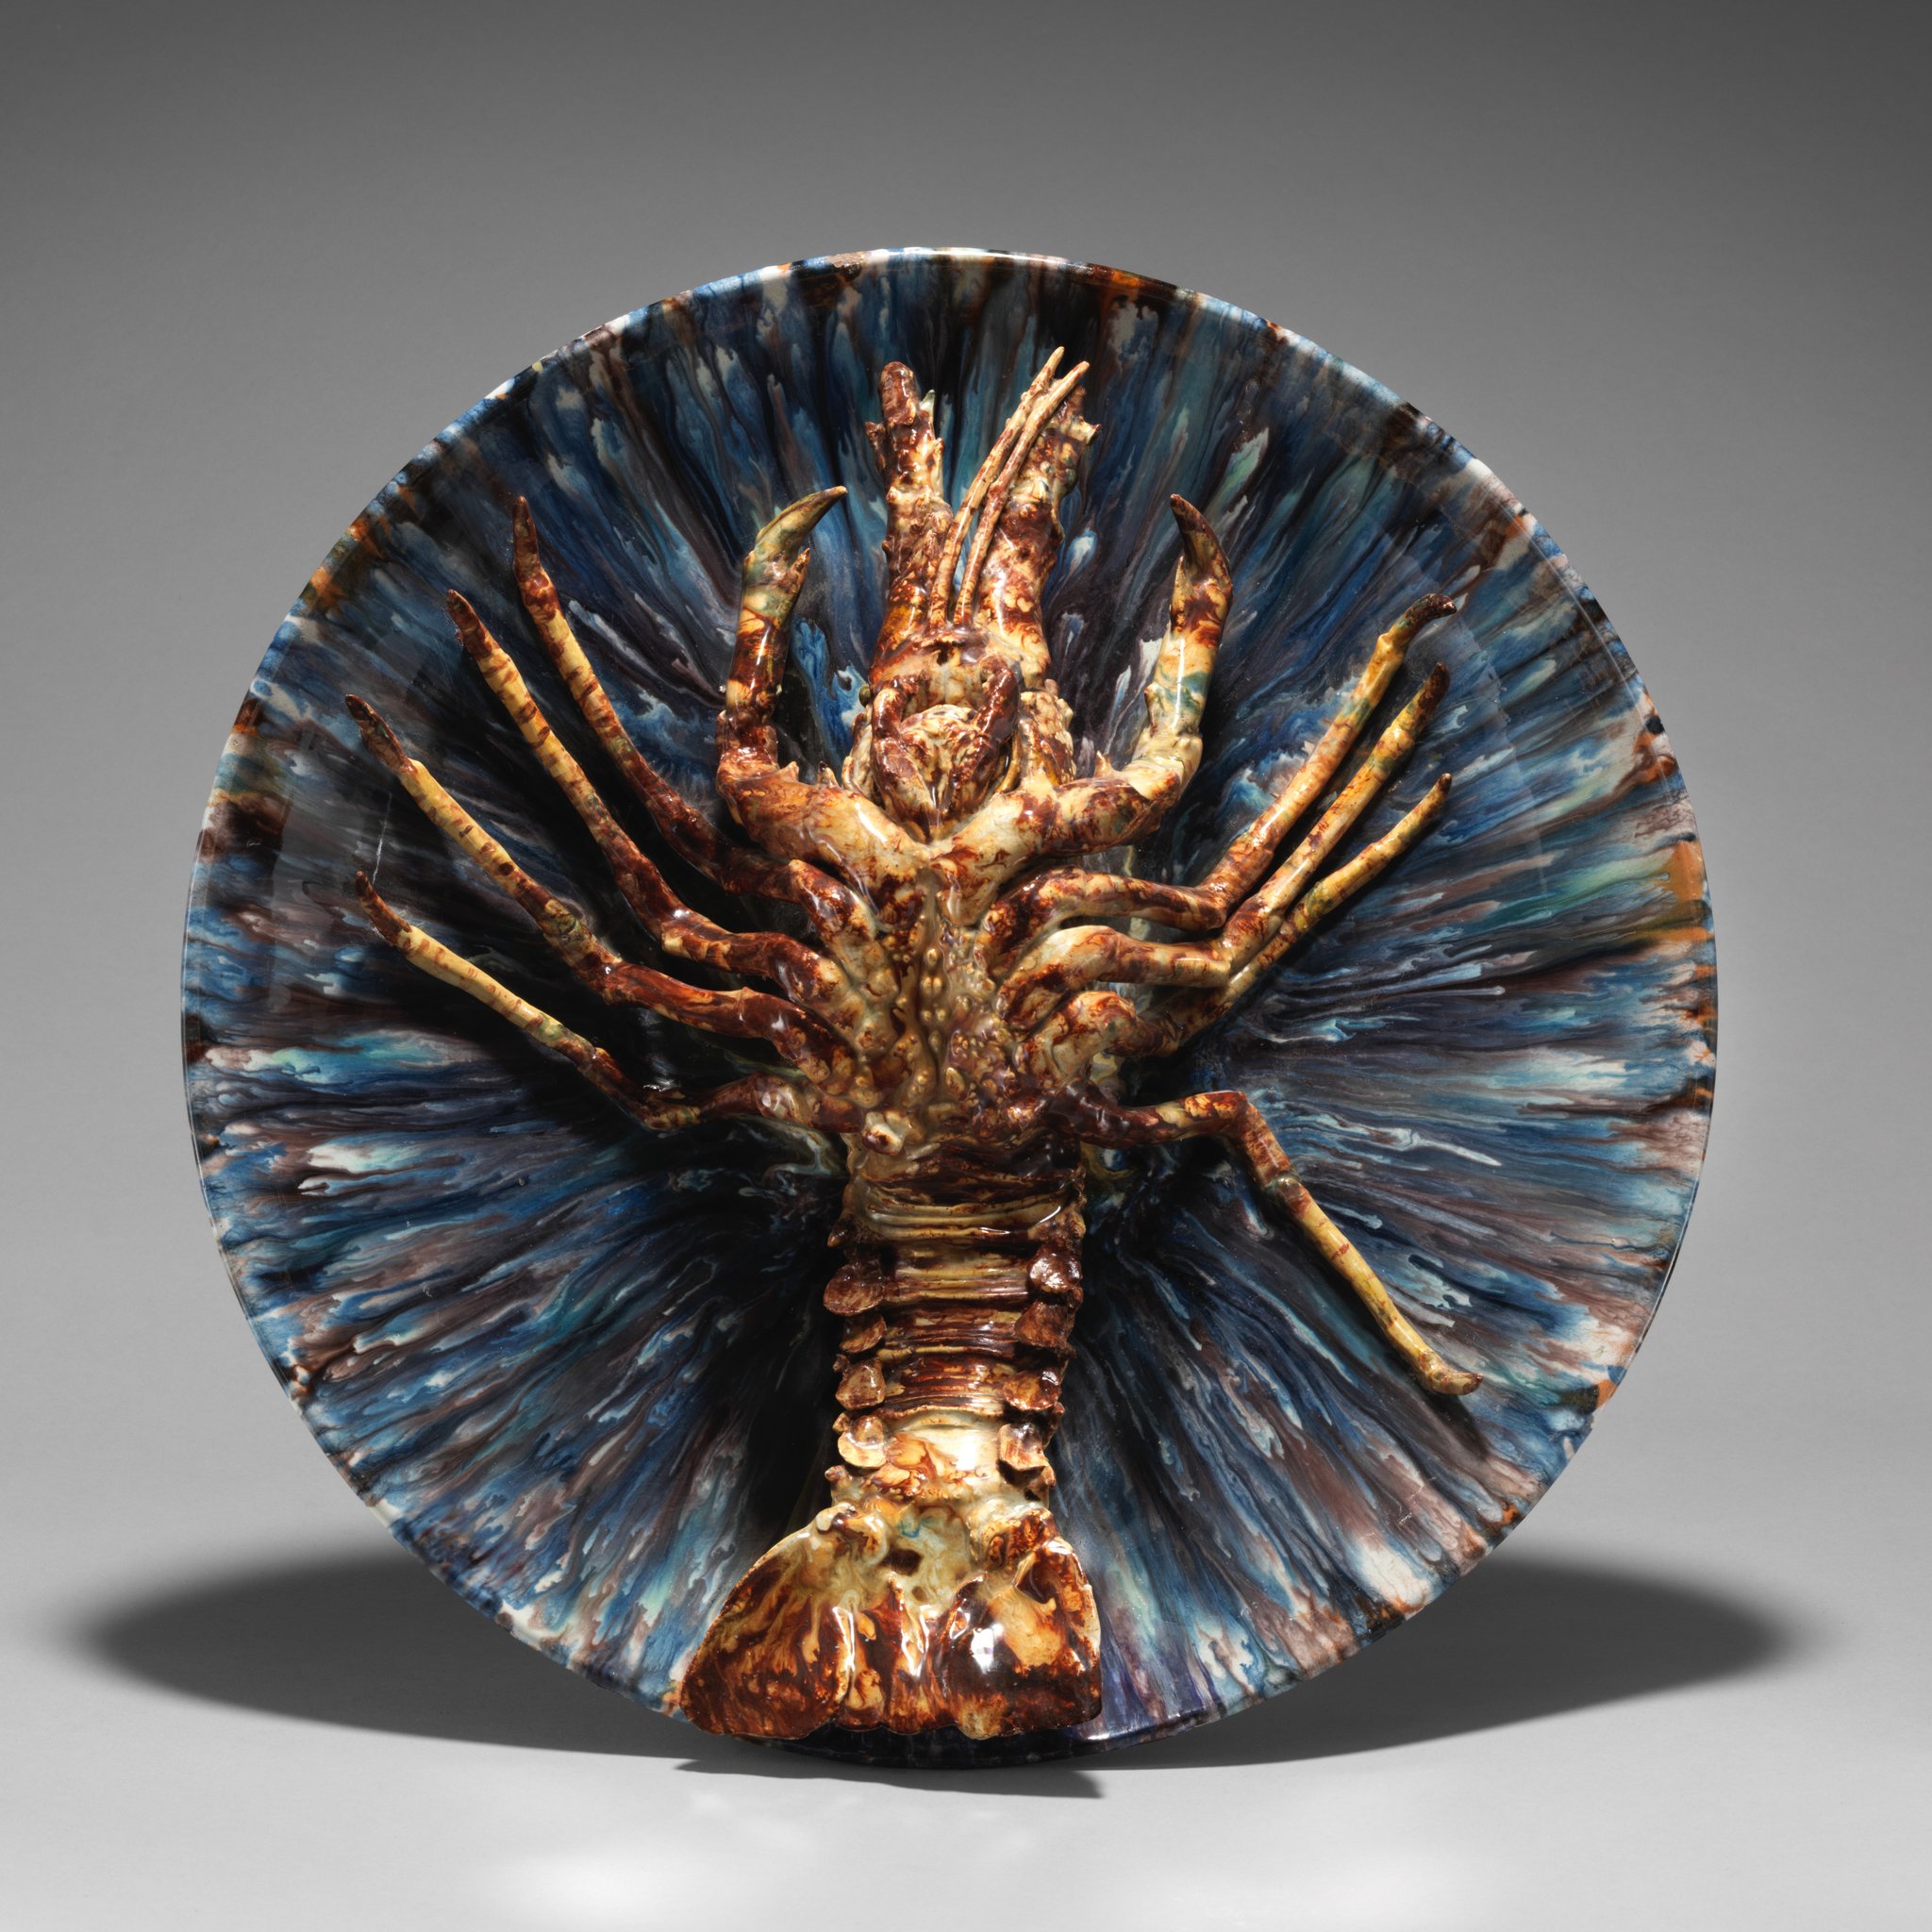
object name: dish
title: Round plate with lobster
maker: rafael bordalo pinheiro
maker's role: maker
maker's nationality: portuguese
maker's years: 1846-1905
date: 1889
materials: earthenware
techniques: glazing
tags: lobsters